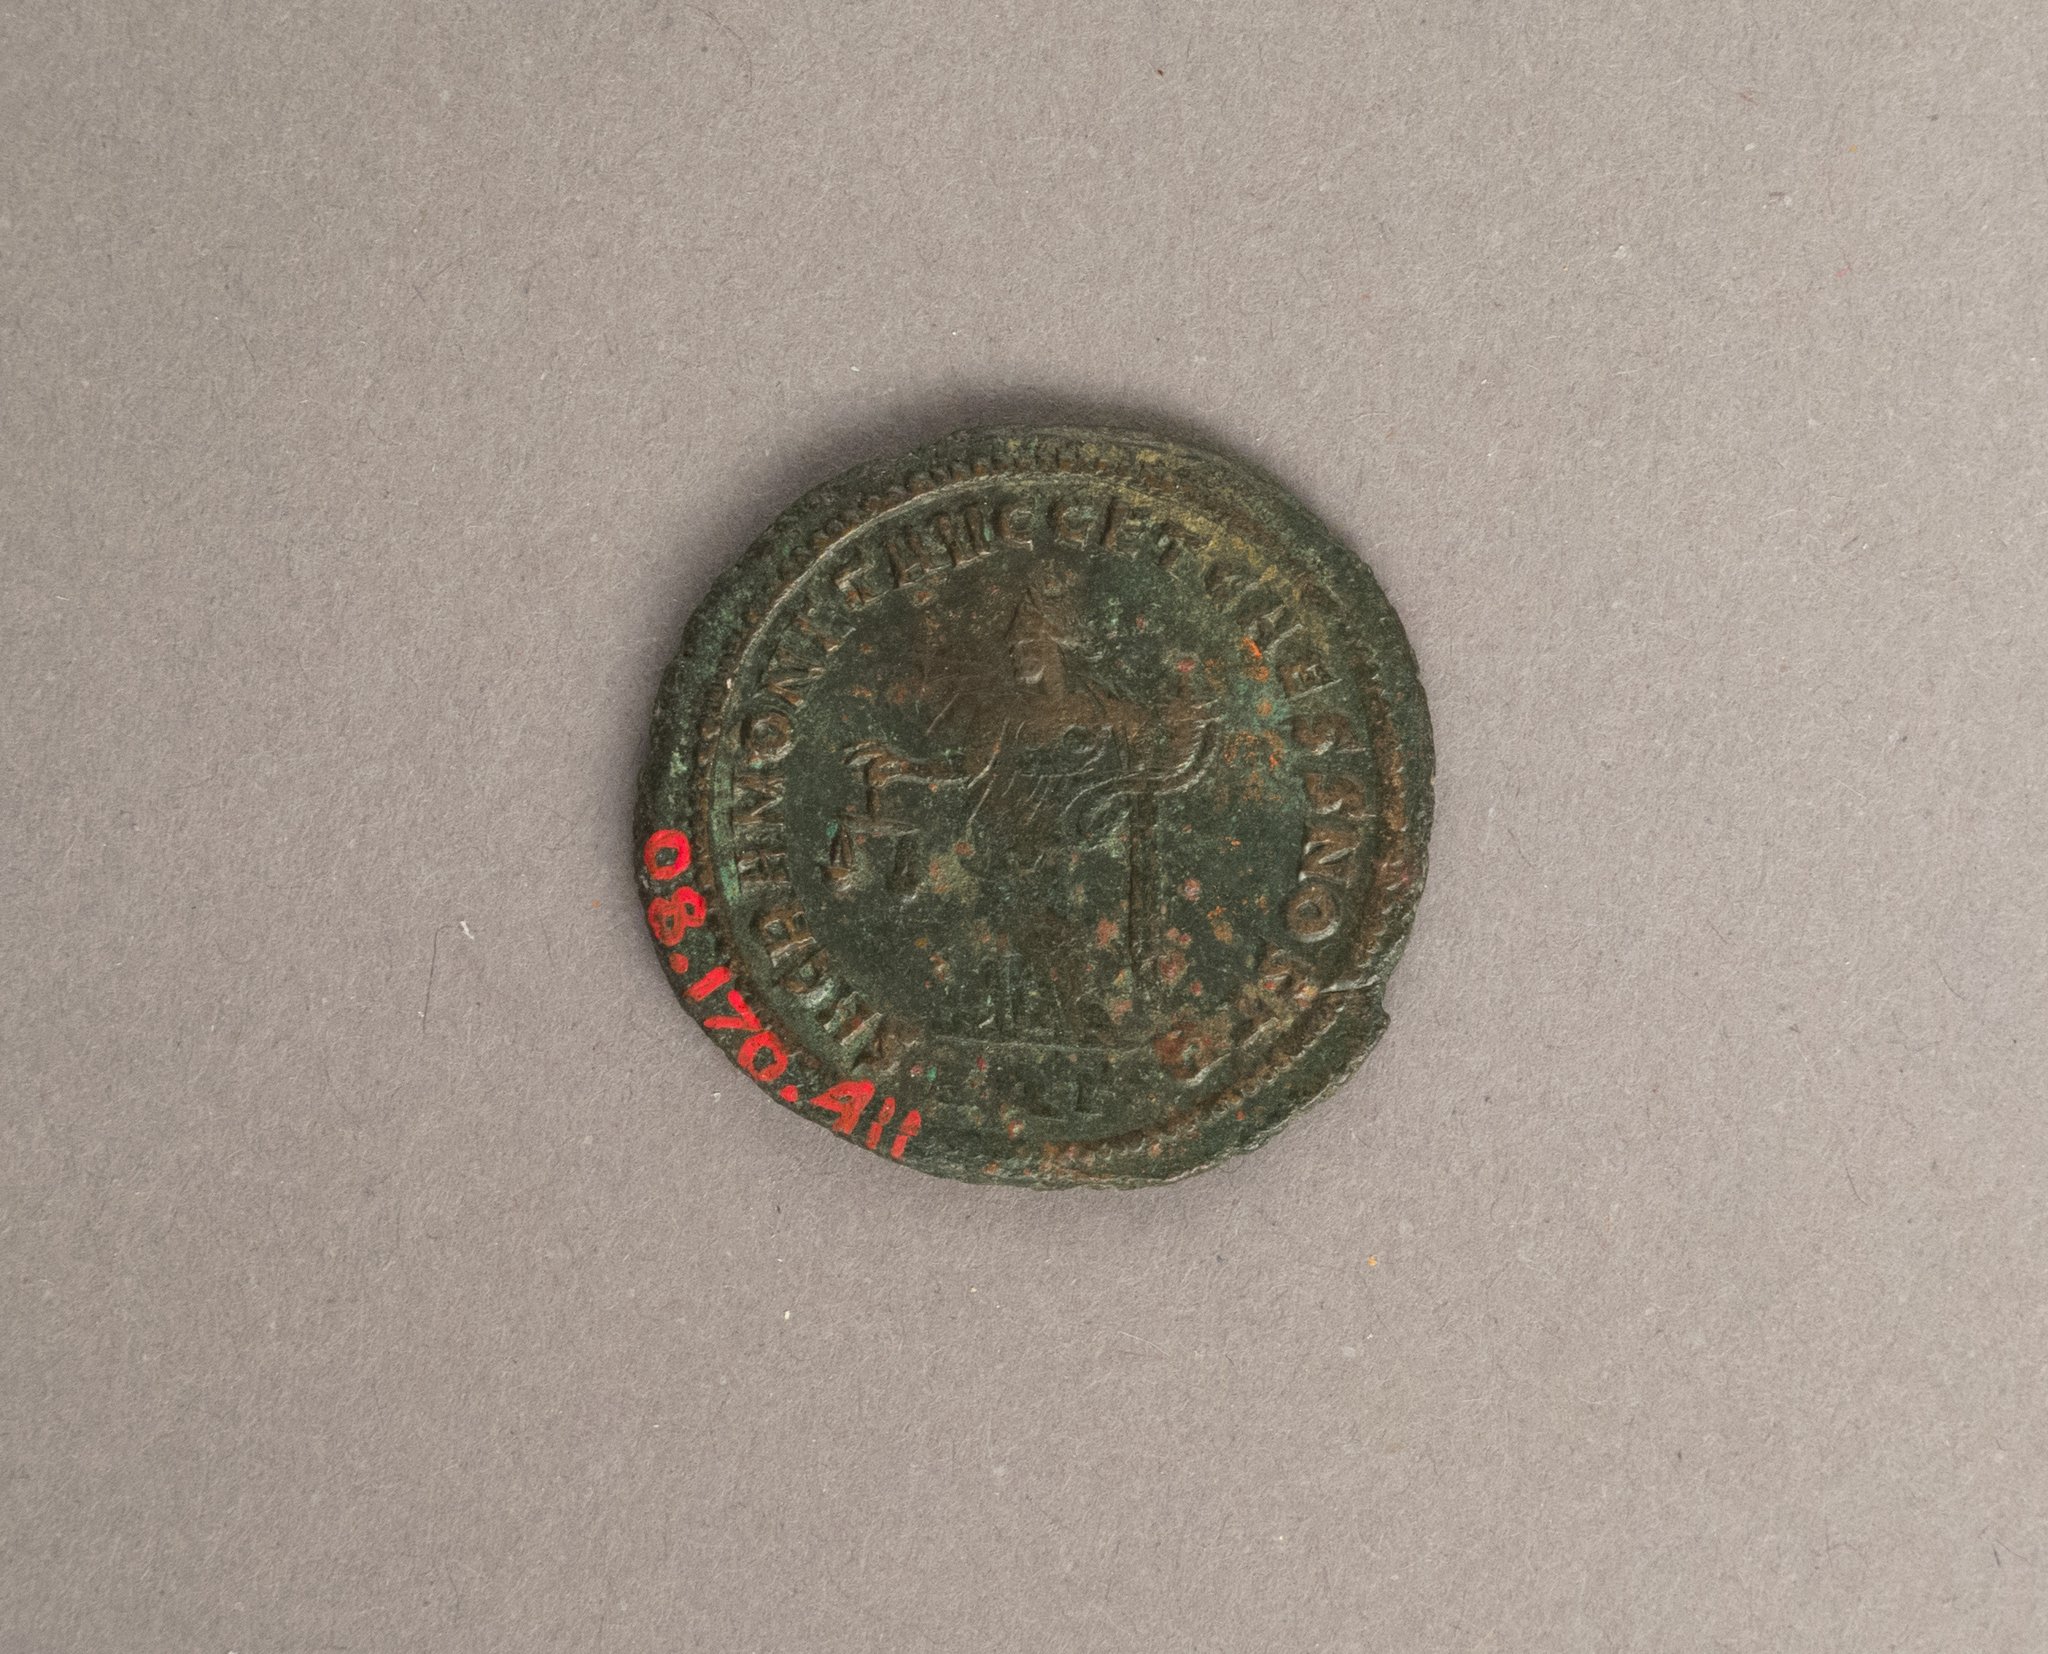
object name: nummus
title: Bronze nummus of Constantius I Chlorus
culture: roman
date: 300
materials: bronze